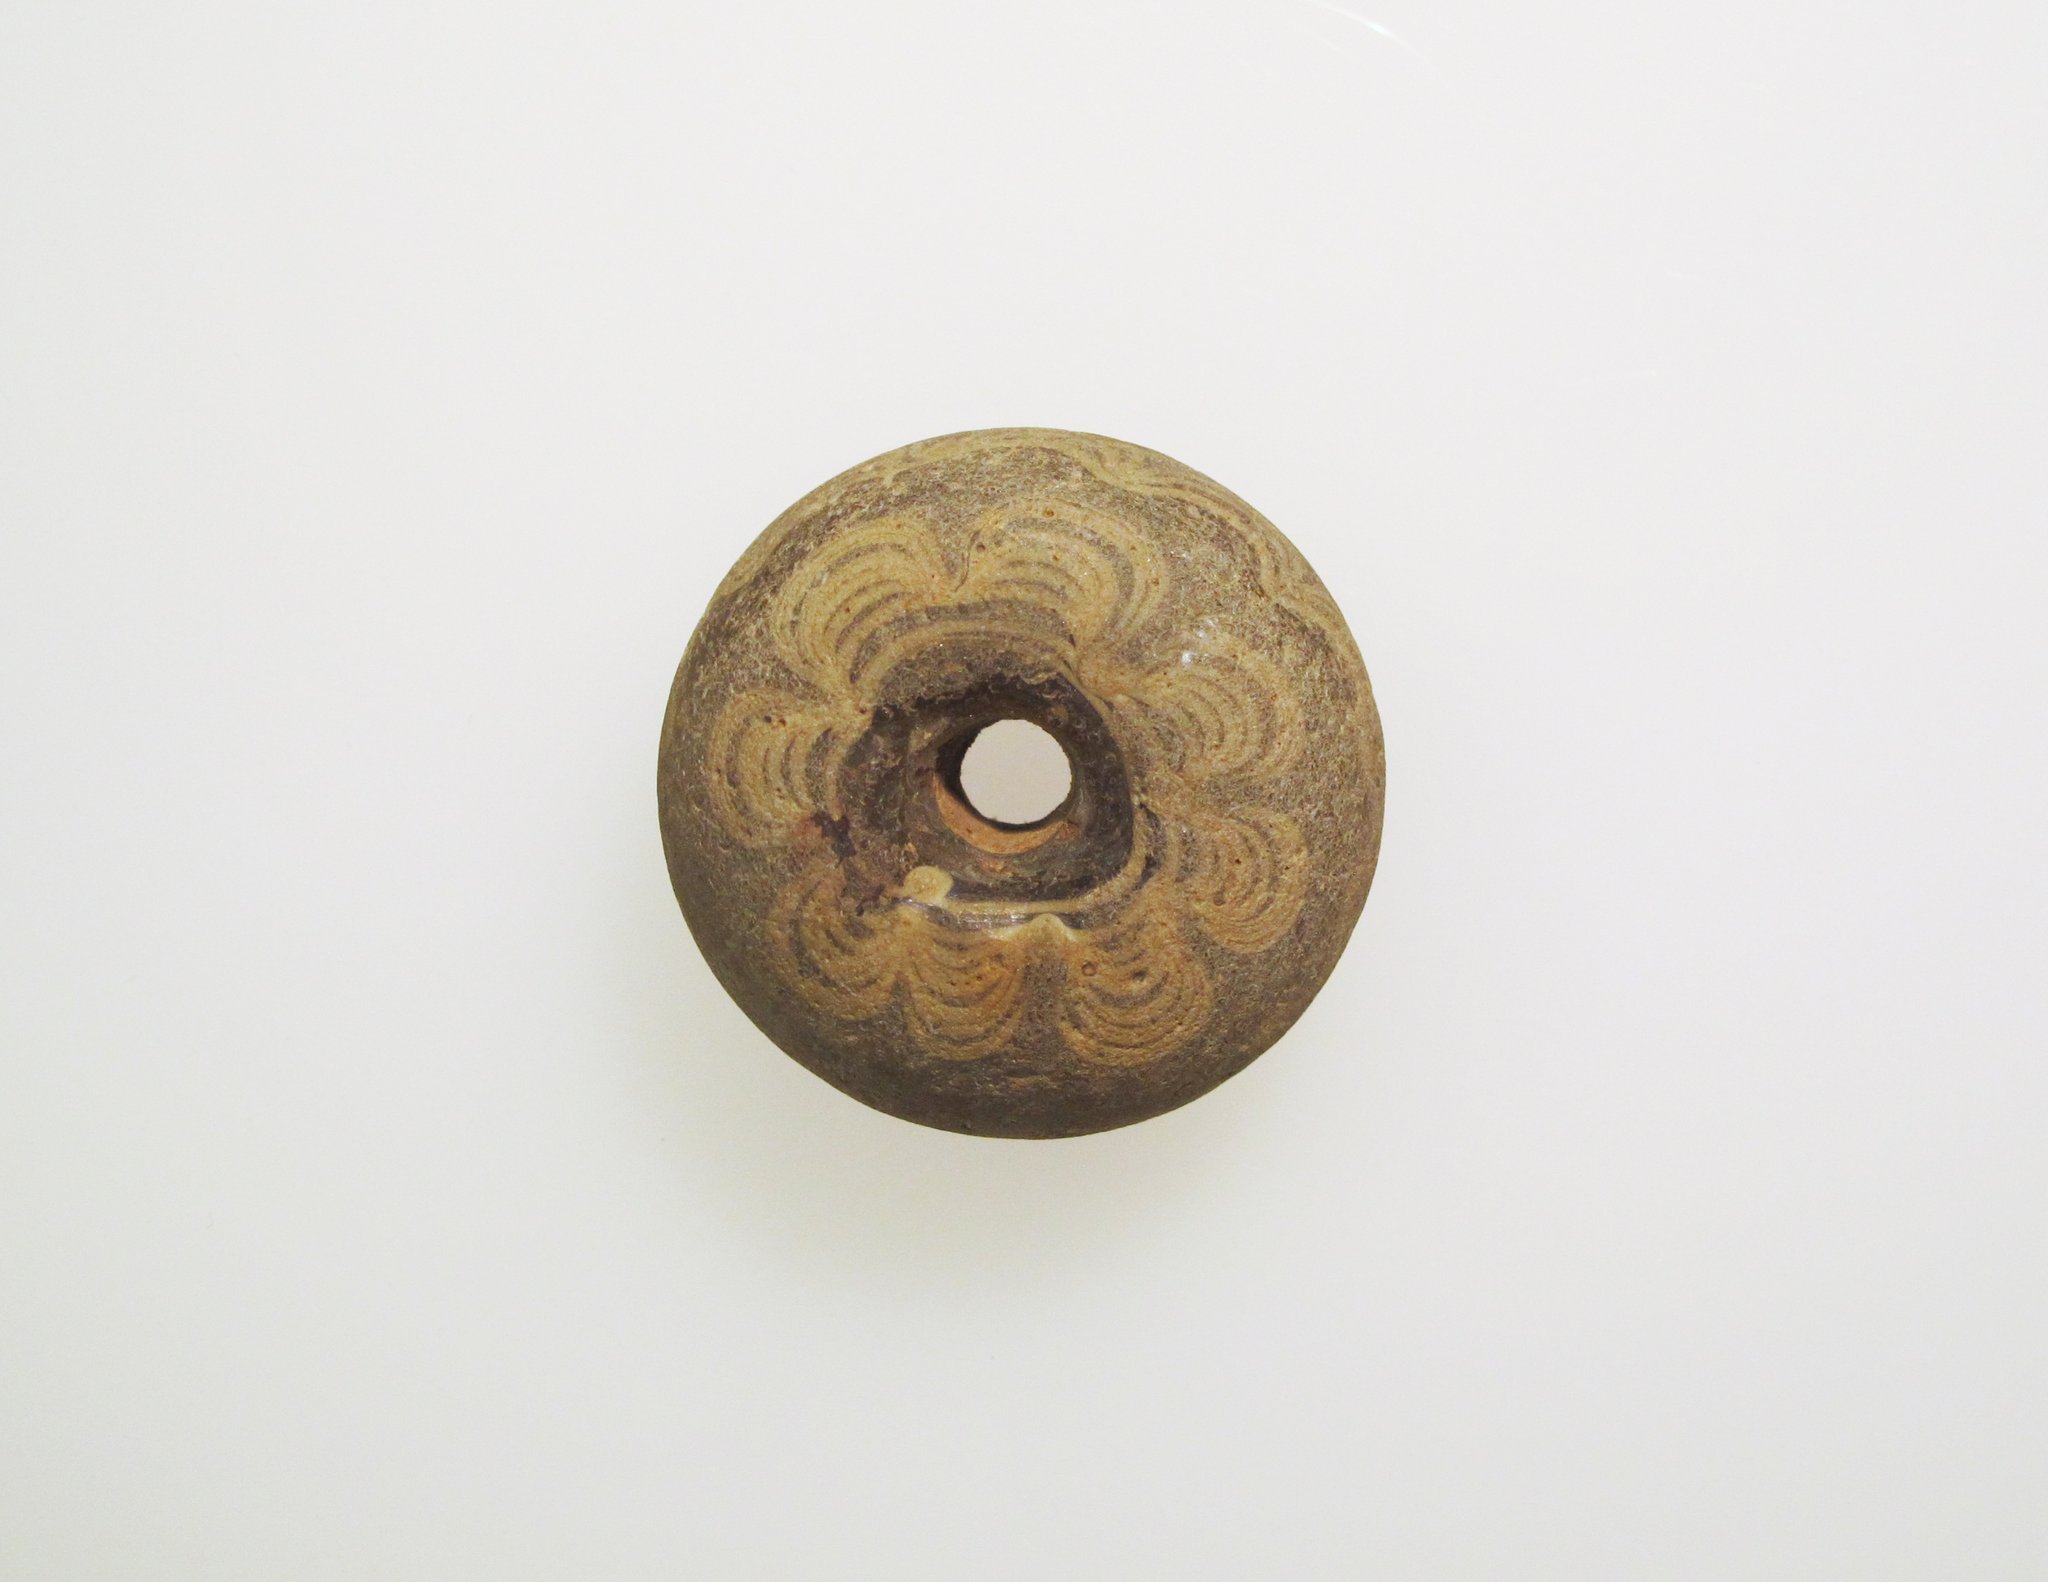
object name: bead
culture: roman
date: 670 BCE-330 CE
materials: glass